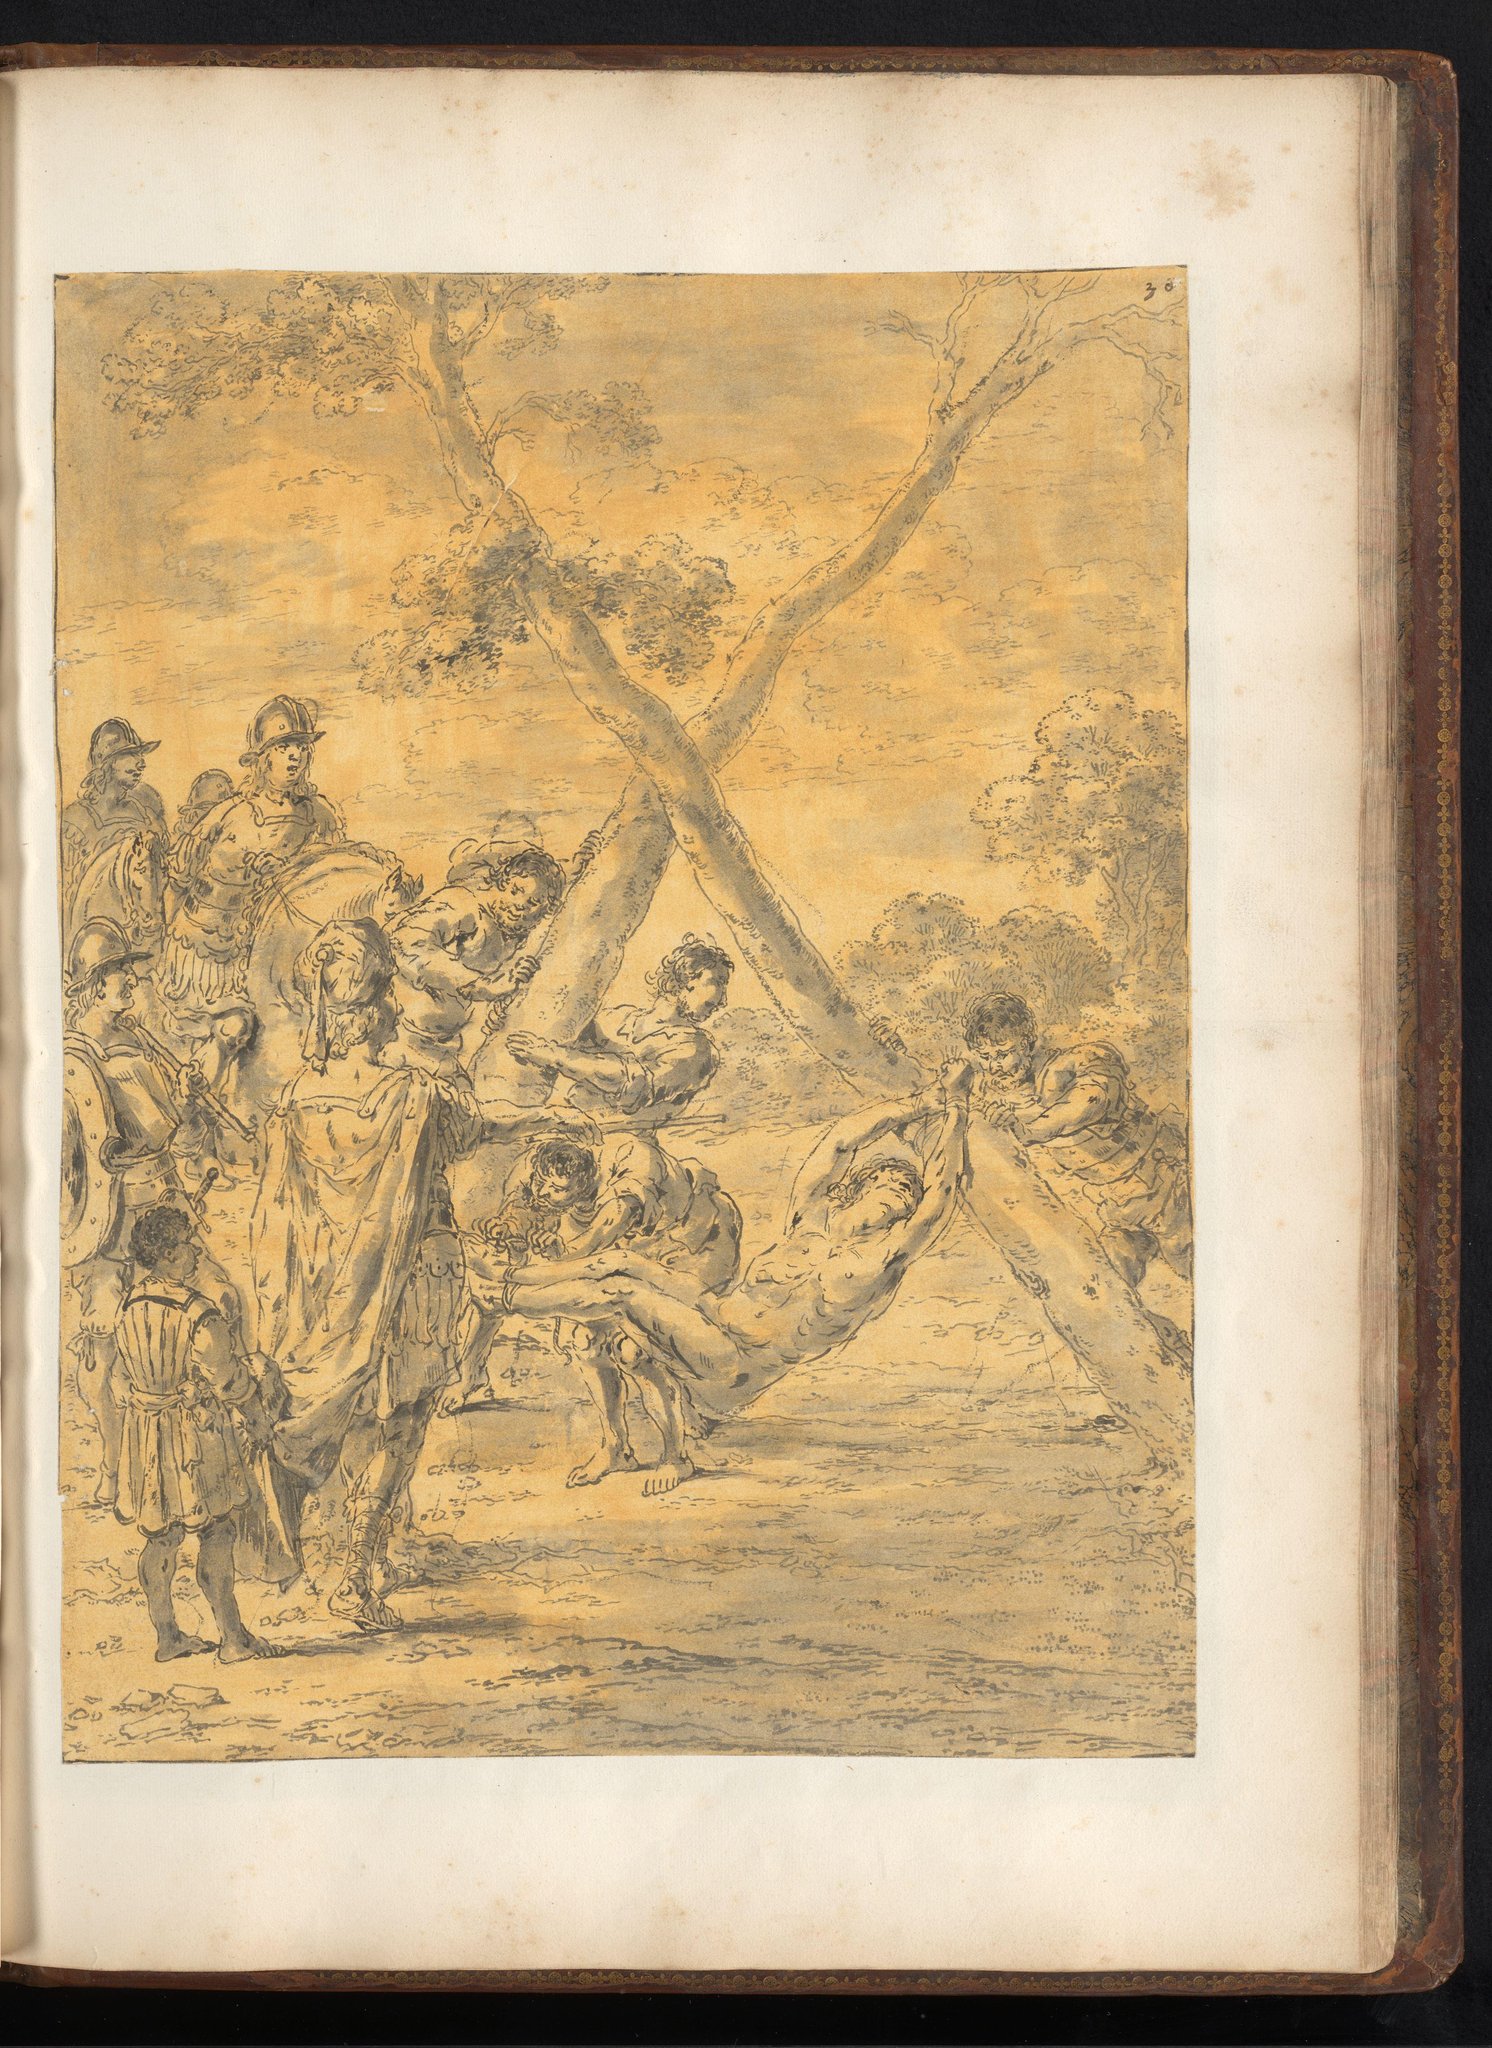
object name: album leaf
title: Alexander de Grote stelt Bessus terecht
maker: leonaert bramer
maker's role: draughtsman, painter, print maker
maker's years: 1596-1674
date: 1655-1665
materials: ink, paper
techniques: brush, pen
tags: (story of) alexander the great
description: Bessus, de moordenaar van Darius III, wordt terechtgesteld door tussen twee naar elkaar gebogen bomen gebonden te worden die vervolgens worden losgelaten en zijn lichaam in tweeën scheuren. Alexander de Grote staat links op de voorgrond en kijkt hoe zijn soldaten Bessus vastbinden. Rechtsboven genummerd: 30. Tekening maakt deel uit van een album.